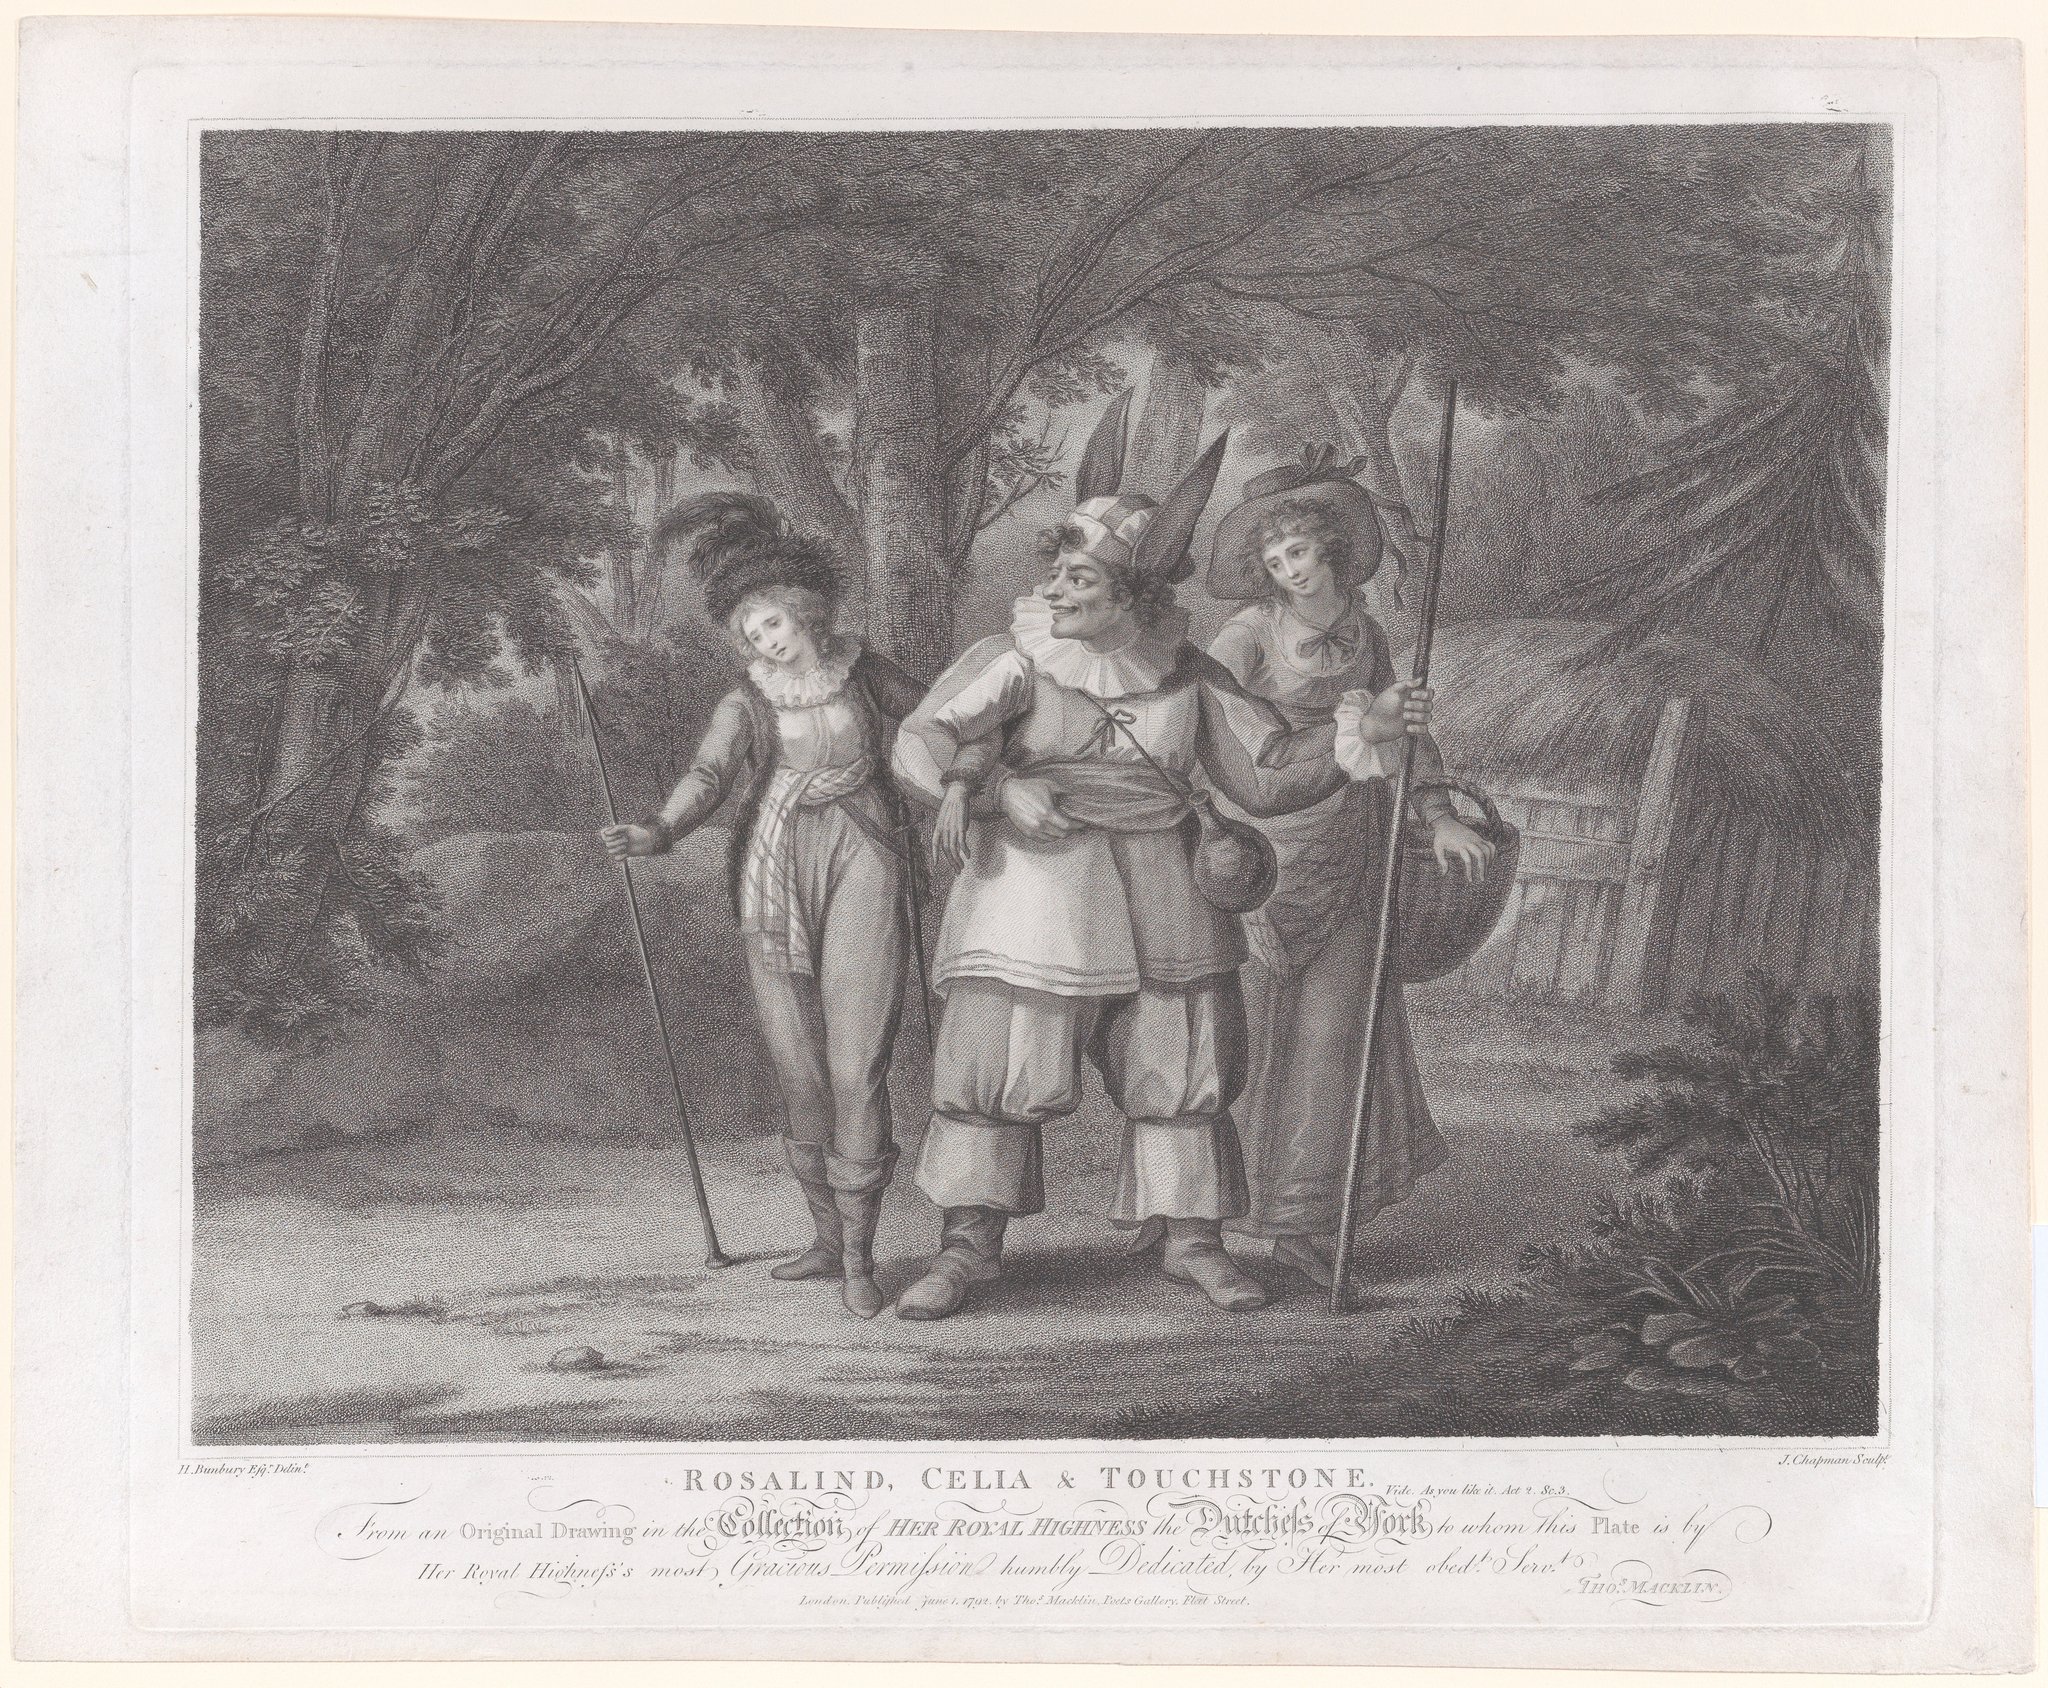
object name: print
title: Rosalind, Celia & Touchstone (Shakespeare, As You Like It, Act 2, Scene 2)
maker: john chapman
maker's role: engraver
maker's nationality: british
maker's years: 1792-1823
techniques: etching, engraving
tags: shakespeare,men,women